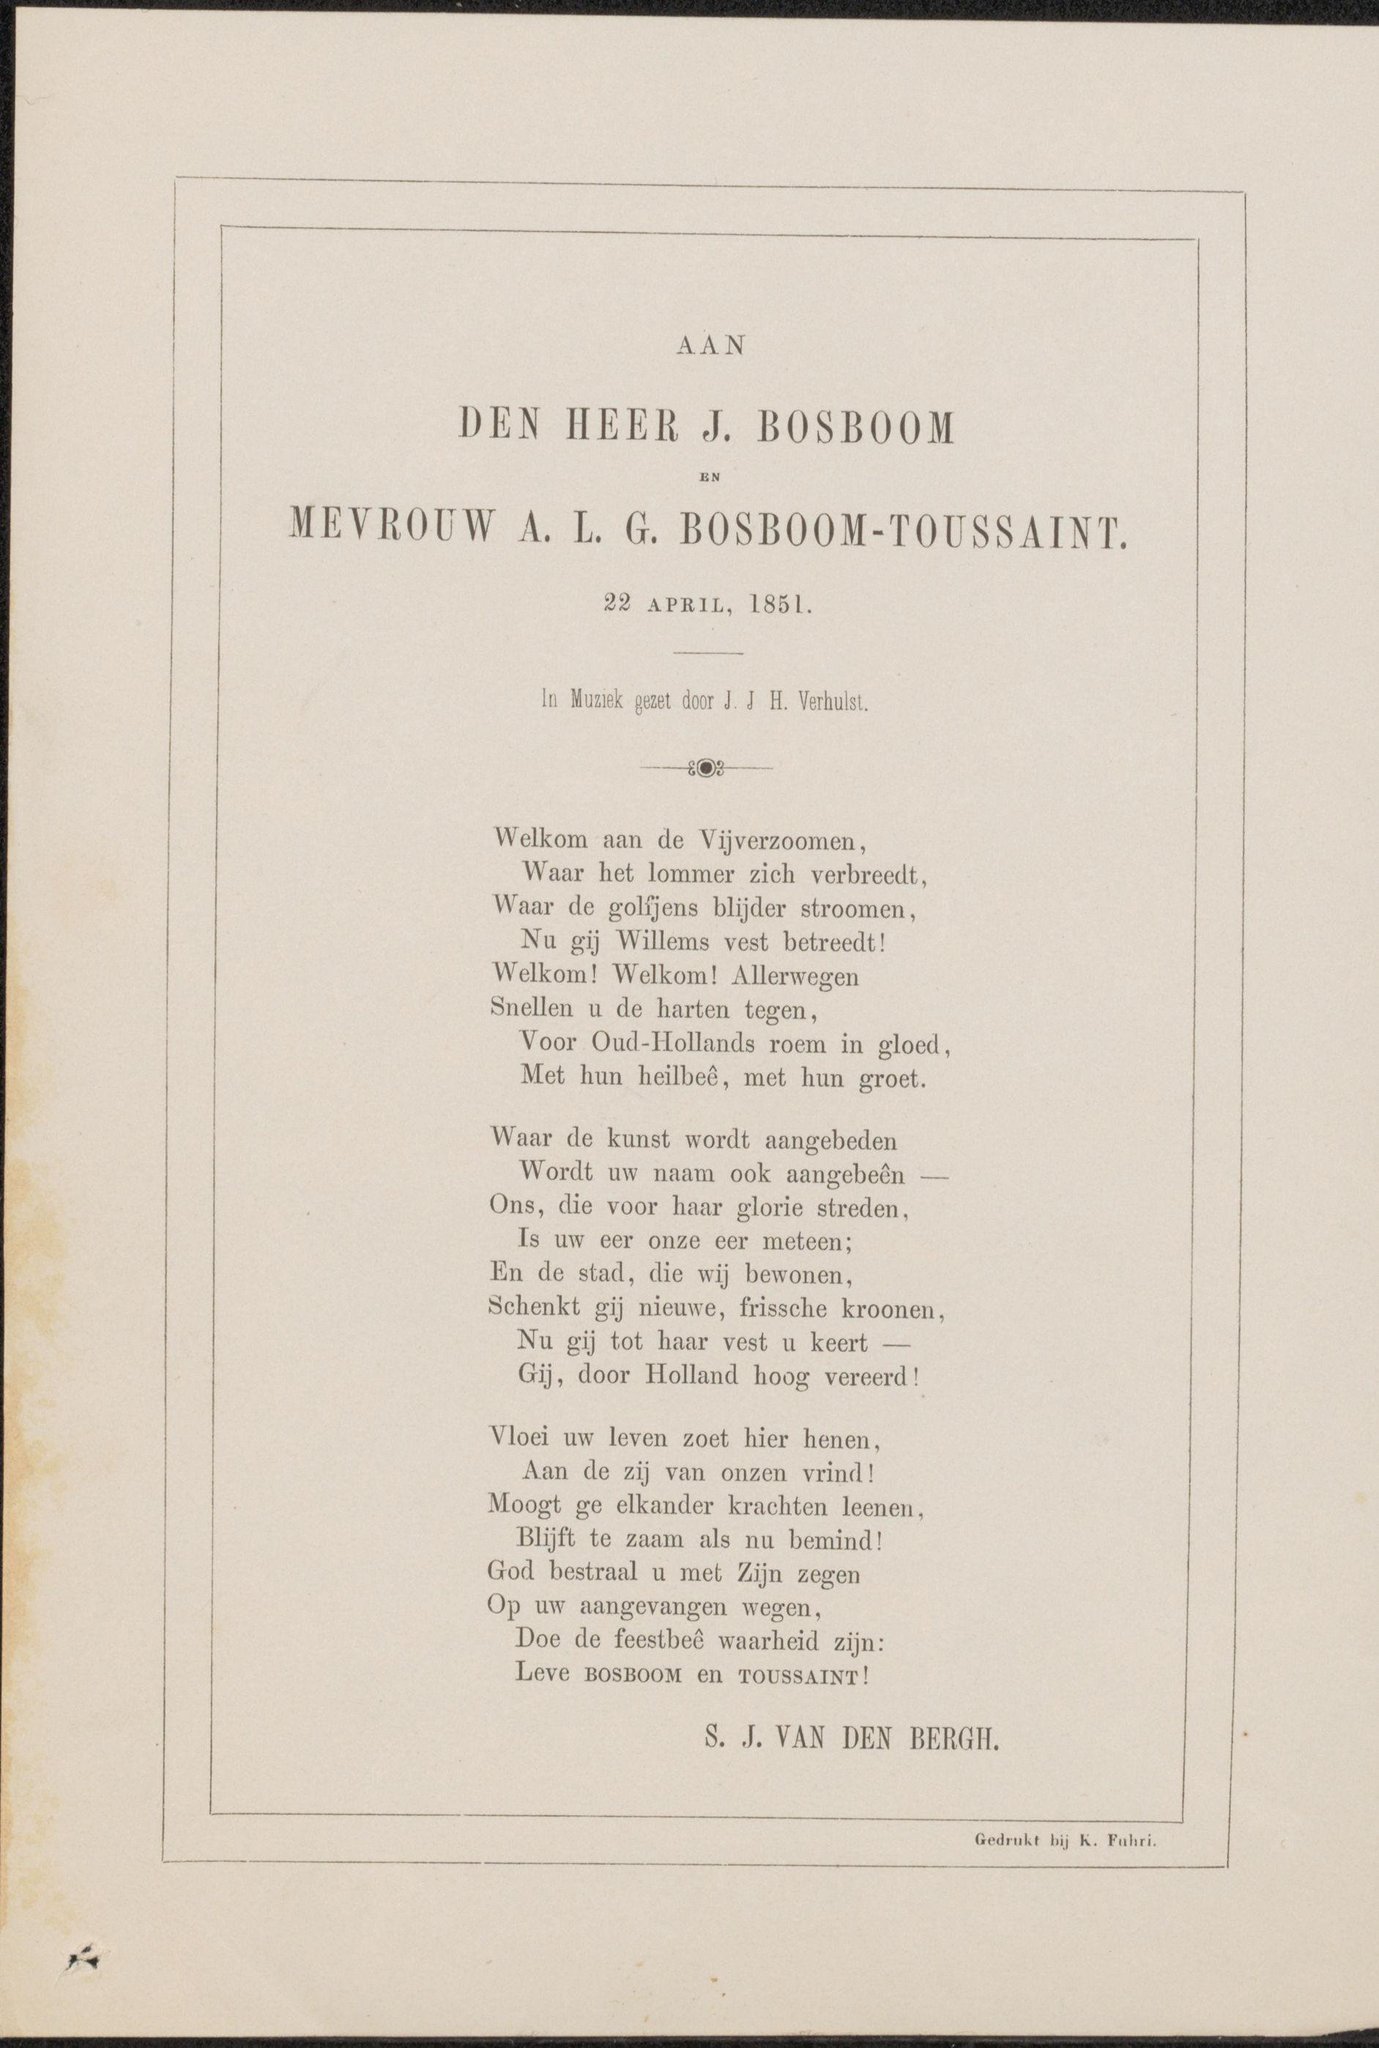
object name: poem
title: Huwelijksgedicht voor Johannes Bosboom en Anna Louisa Geertruyda Bosboom-Toussaint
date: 1851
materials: paper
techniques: printing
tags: painter, print maker, draughtsman, johannes bosboom, anna louisa geertruyda bosboom-toussaint, the hague, johannes verhulst, literature ~ arts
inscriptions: collector's mark: Lugt 2233